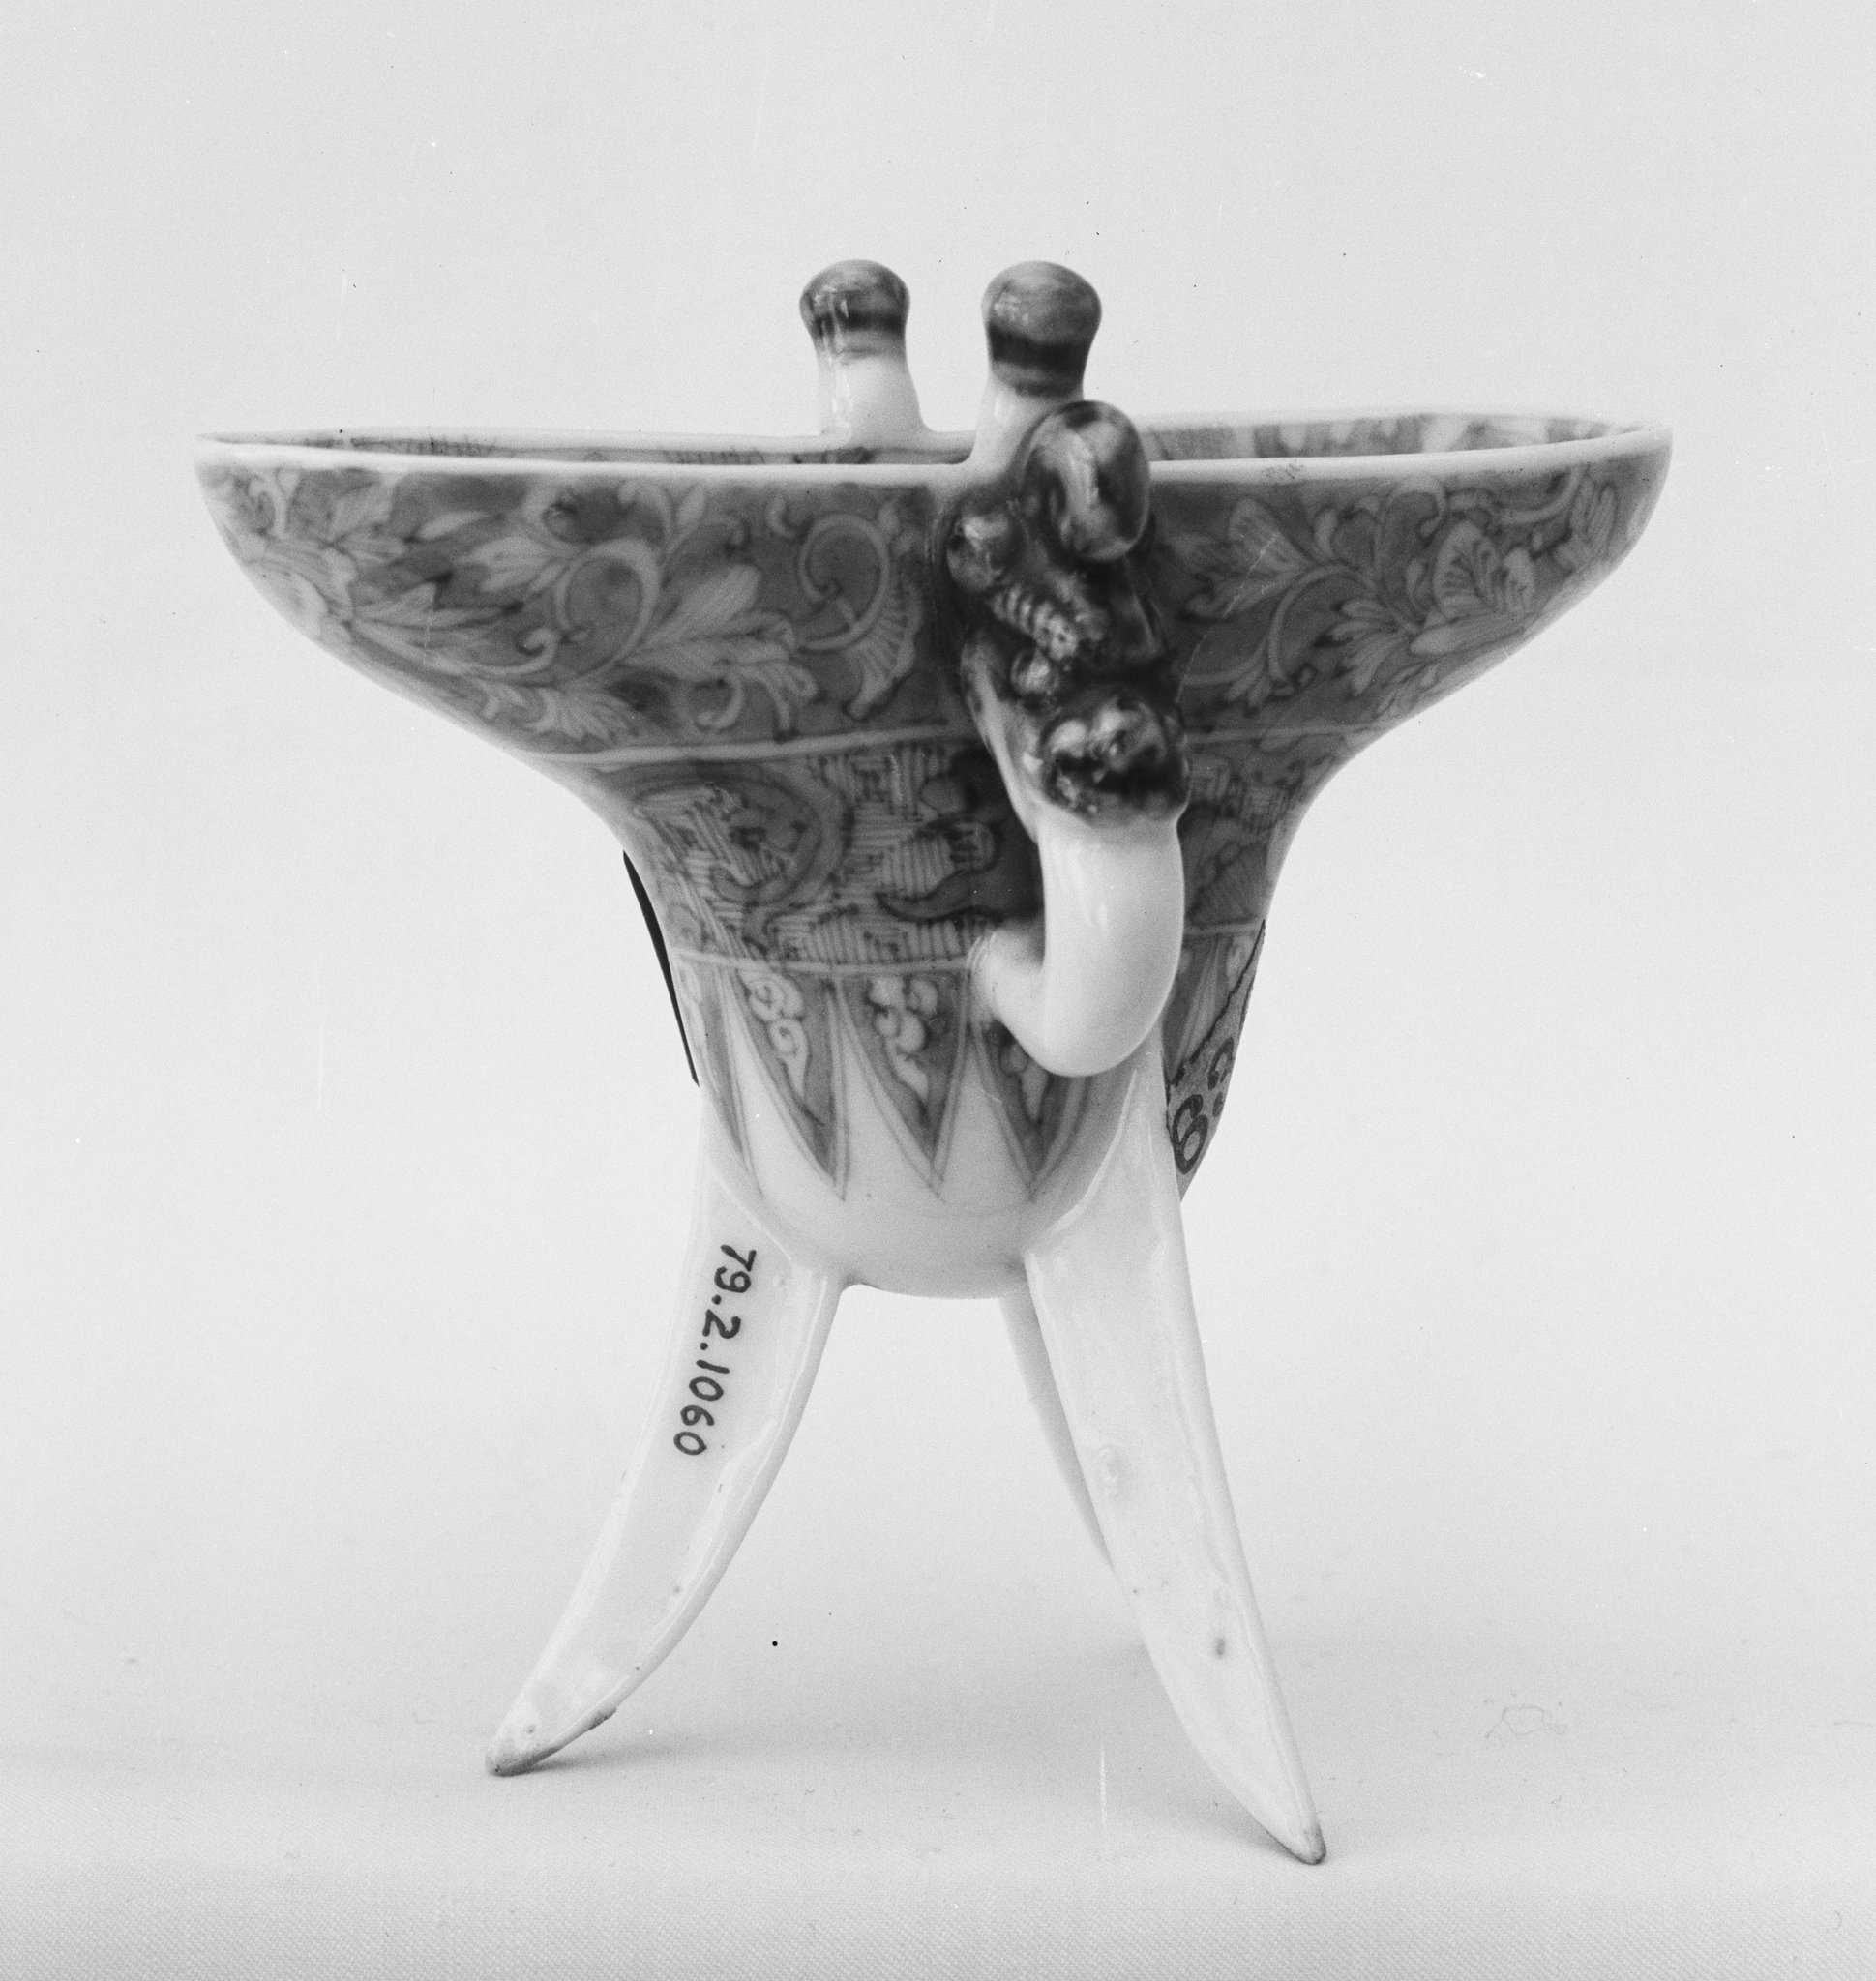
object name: cup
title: Libation Cup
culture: japanese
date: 1701-1800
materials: glaze, porcelain